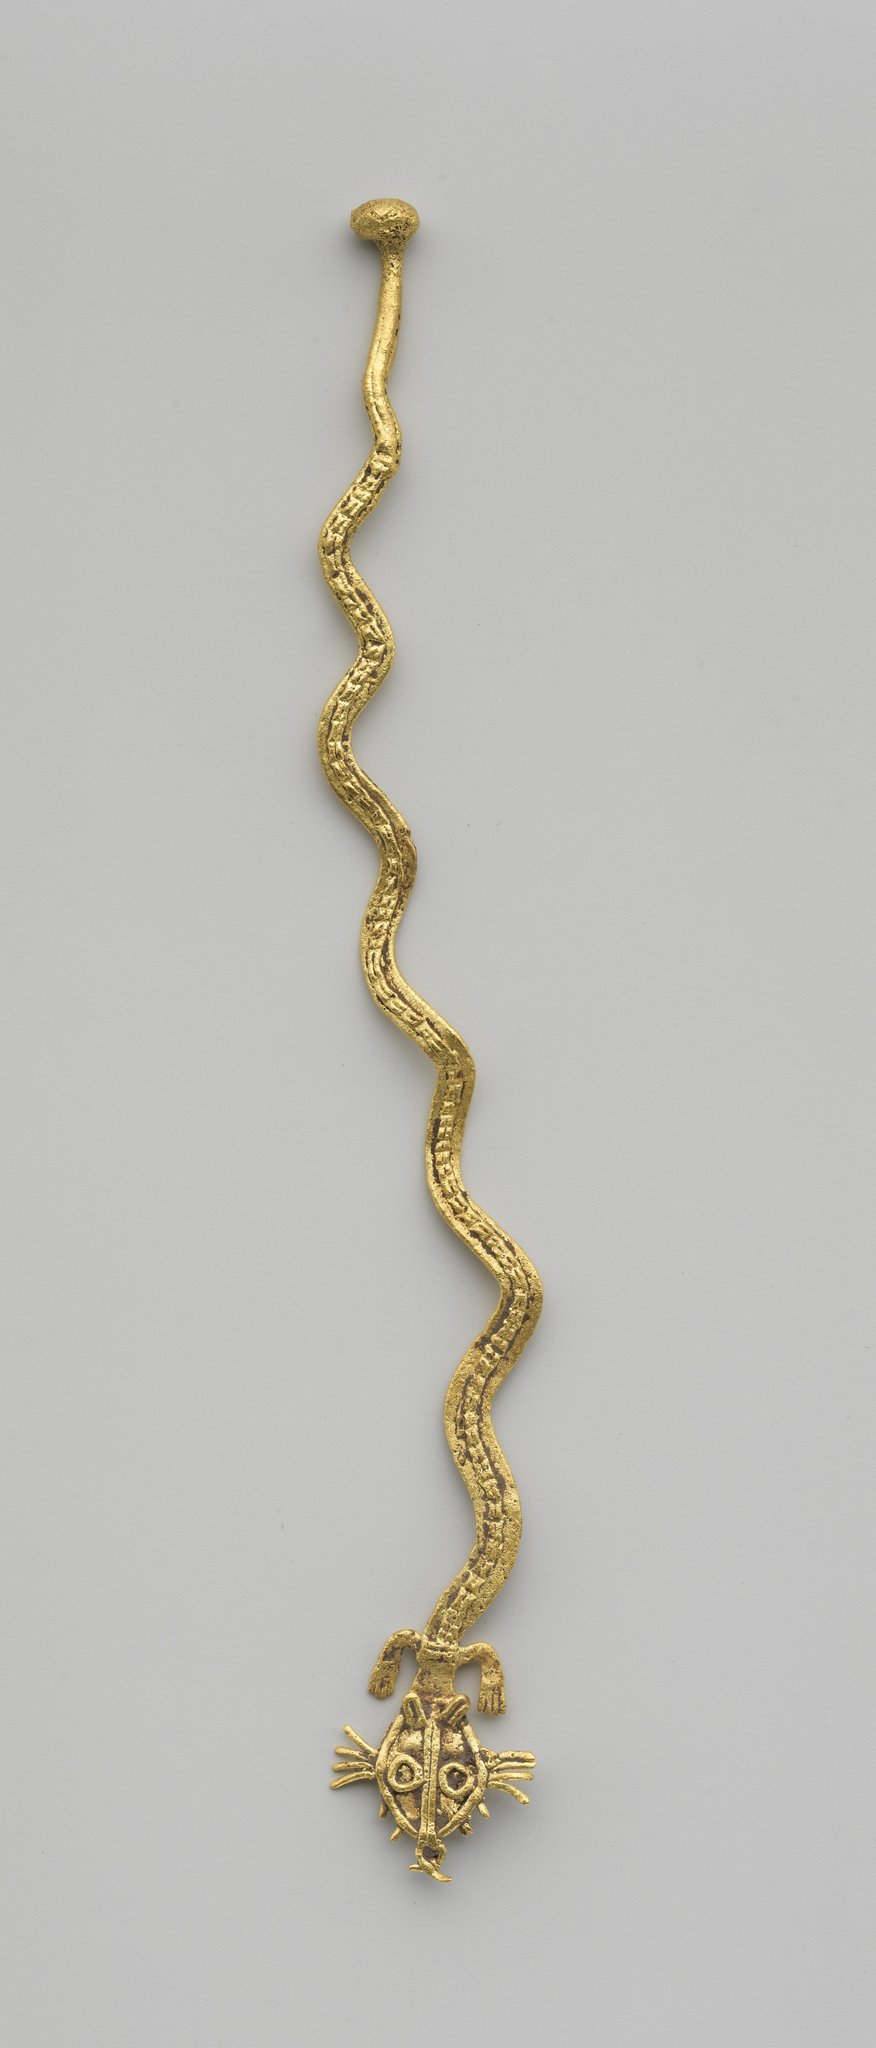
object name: figure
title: Serpent (tunjo)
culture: muisca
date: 901-1600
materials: gold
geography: colombia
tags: serpents